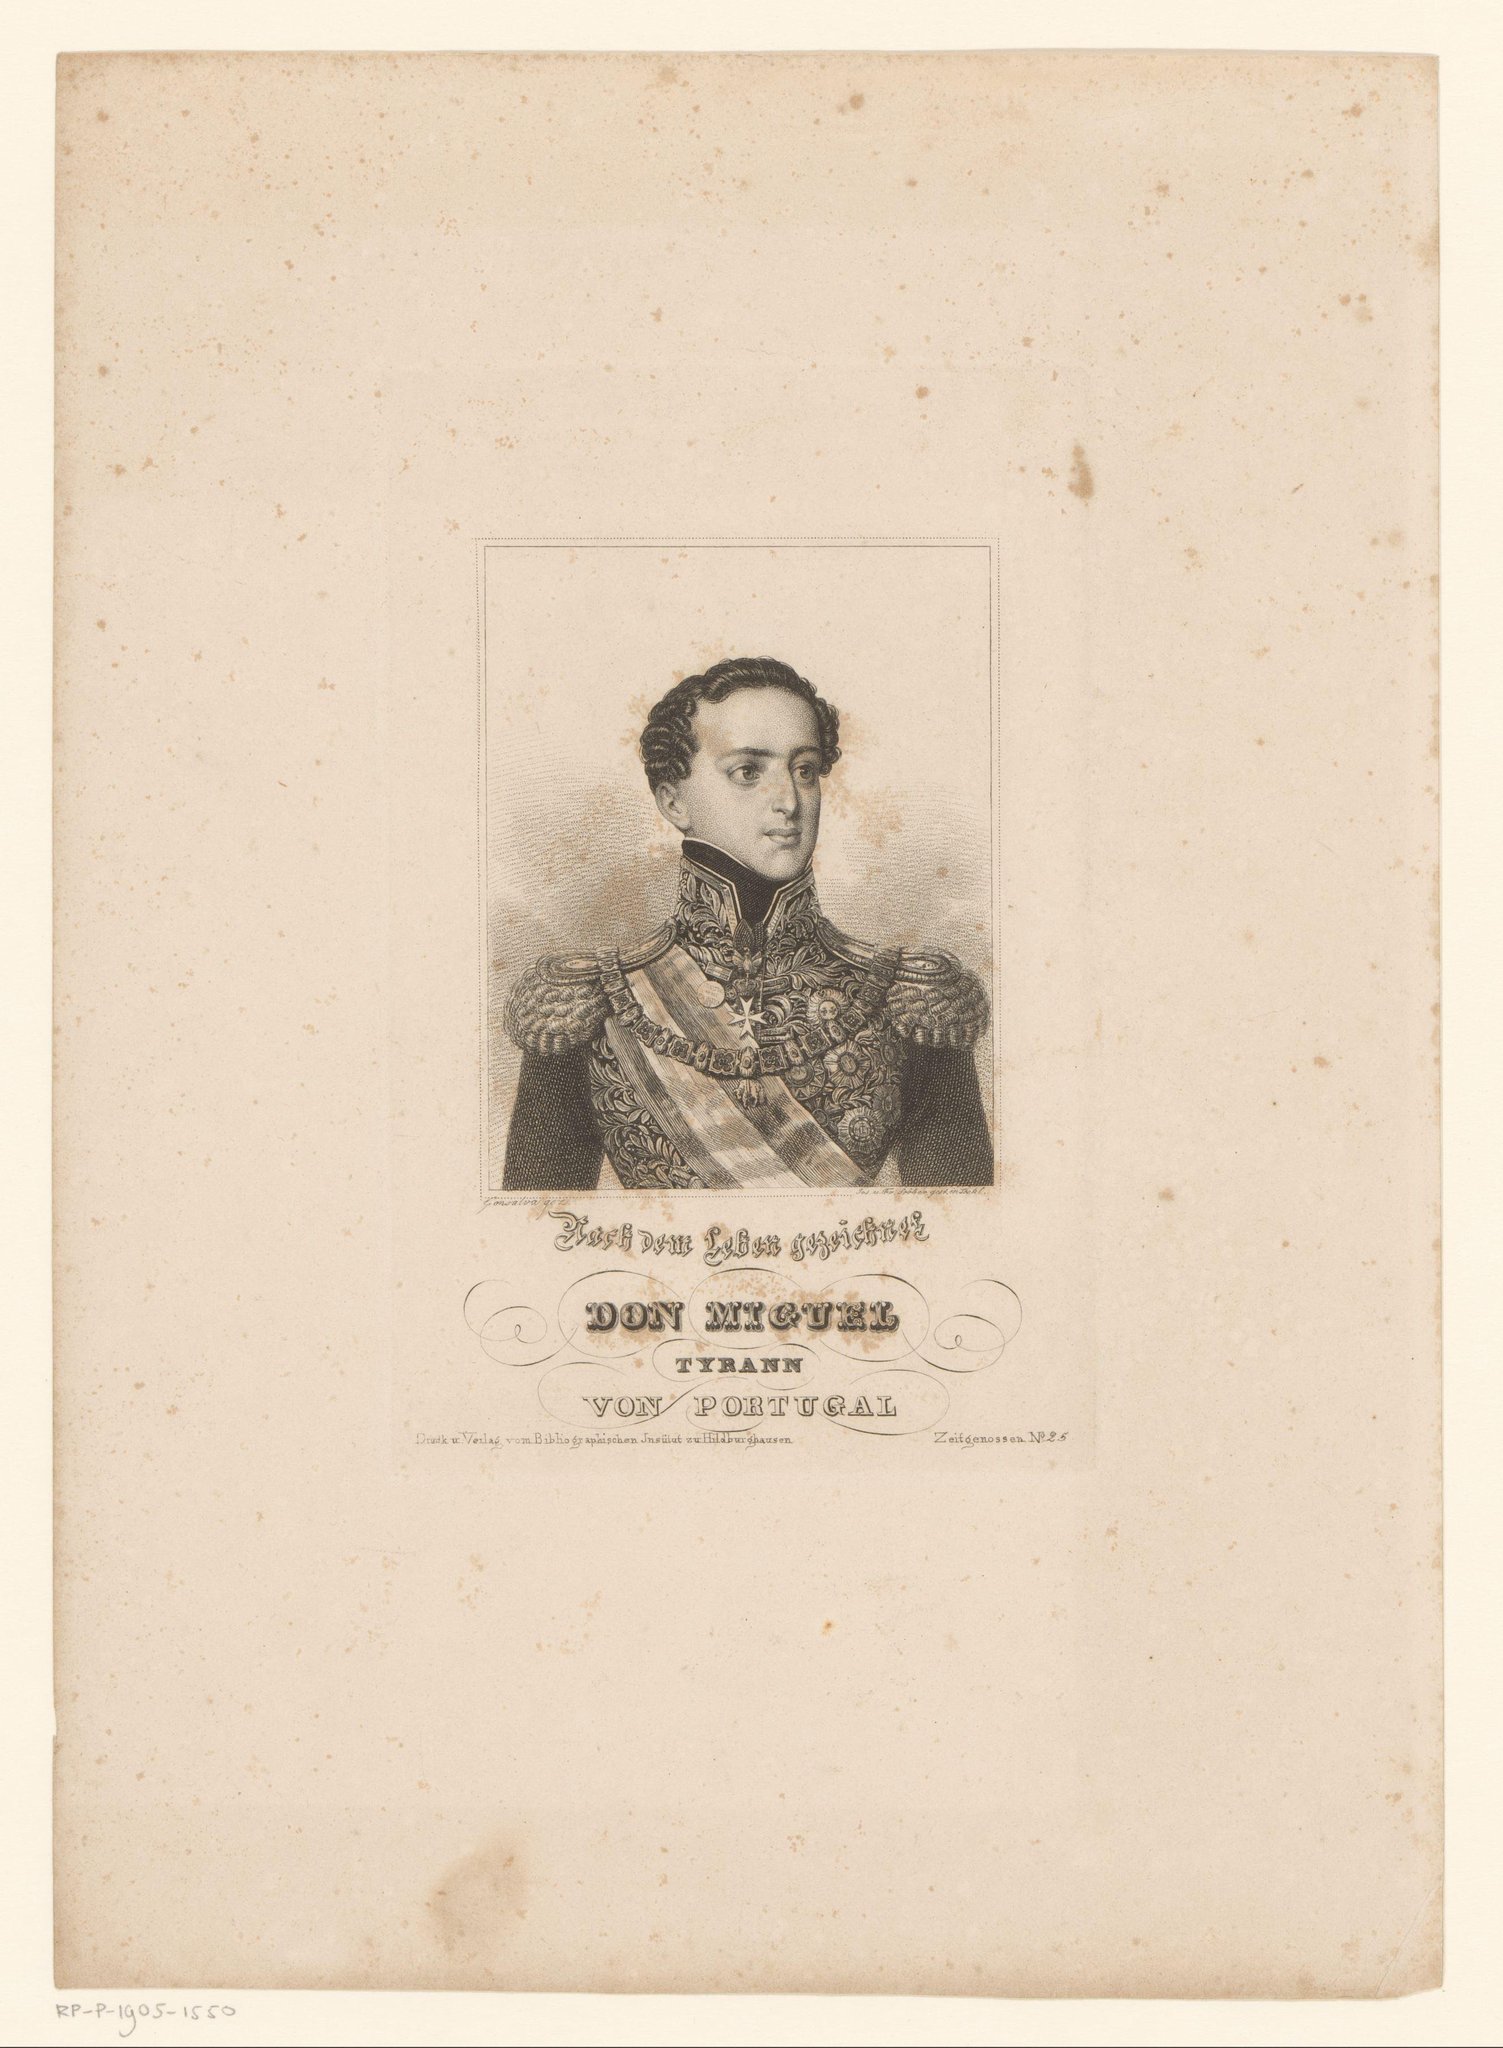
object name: print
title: Portret van Don Miguel, koning van Portugal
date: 1829-1840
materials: paper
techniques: engraving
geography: vienna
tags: historical persons, knighthood order of the golden fleece - insignia of a knighthood order, e.g.: badge, chain (with name of order)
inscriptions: collector's mark: Lugt 2228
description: Afkomstig uit de portretserie 'Zeitgenossen', uitgegeven tussen 1829 en circa 1840.